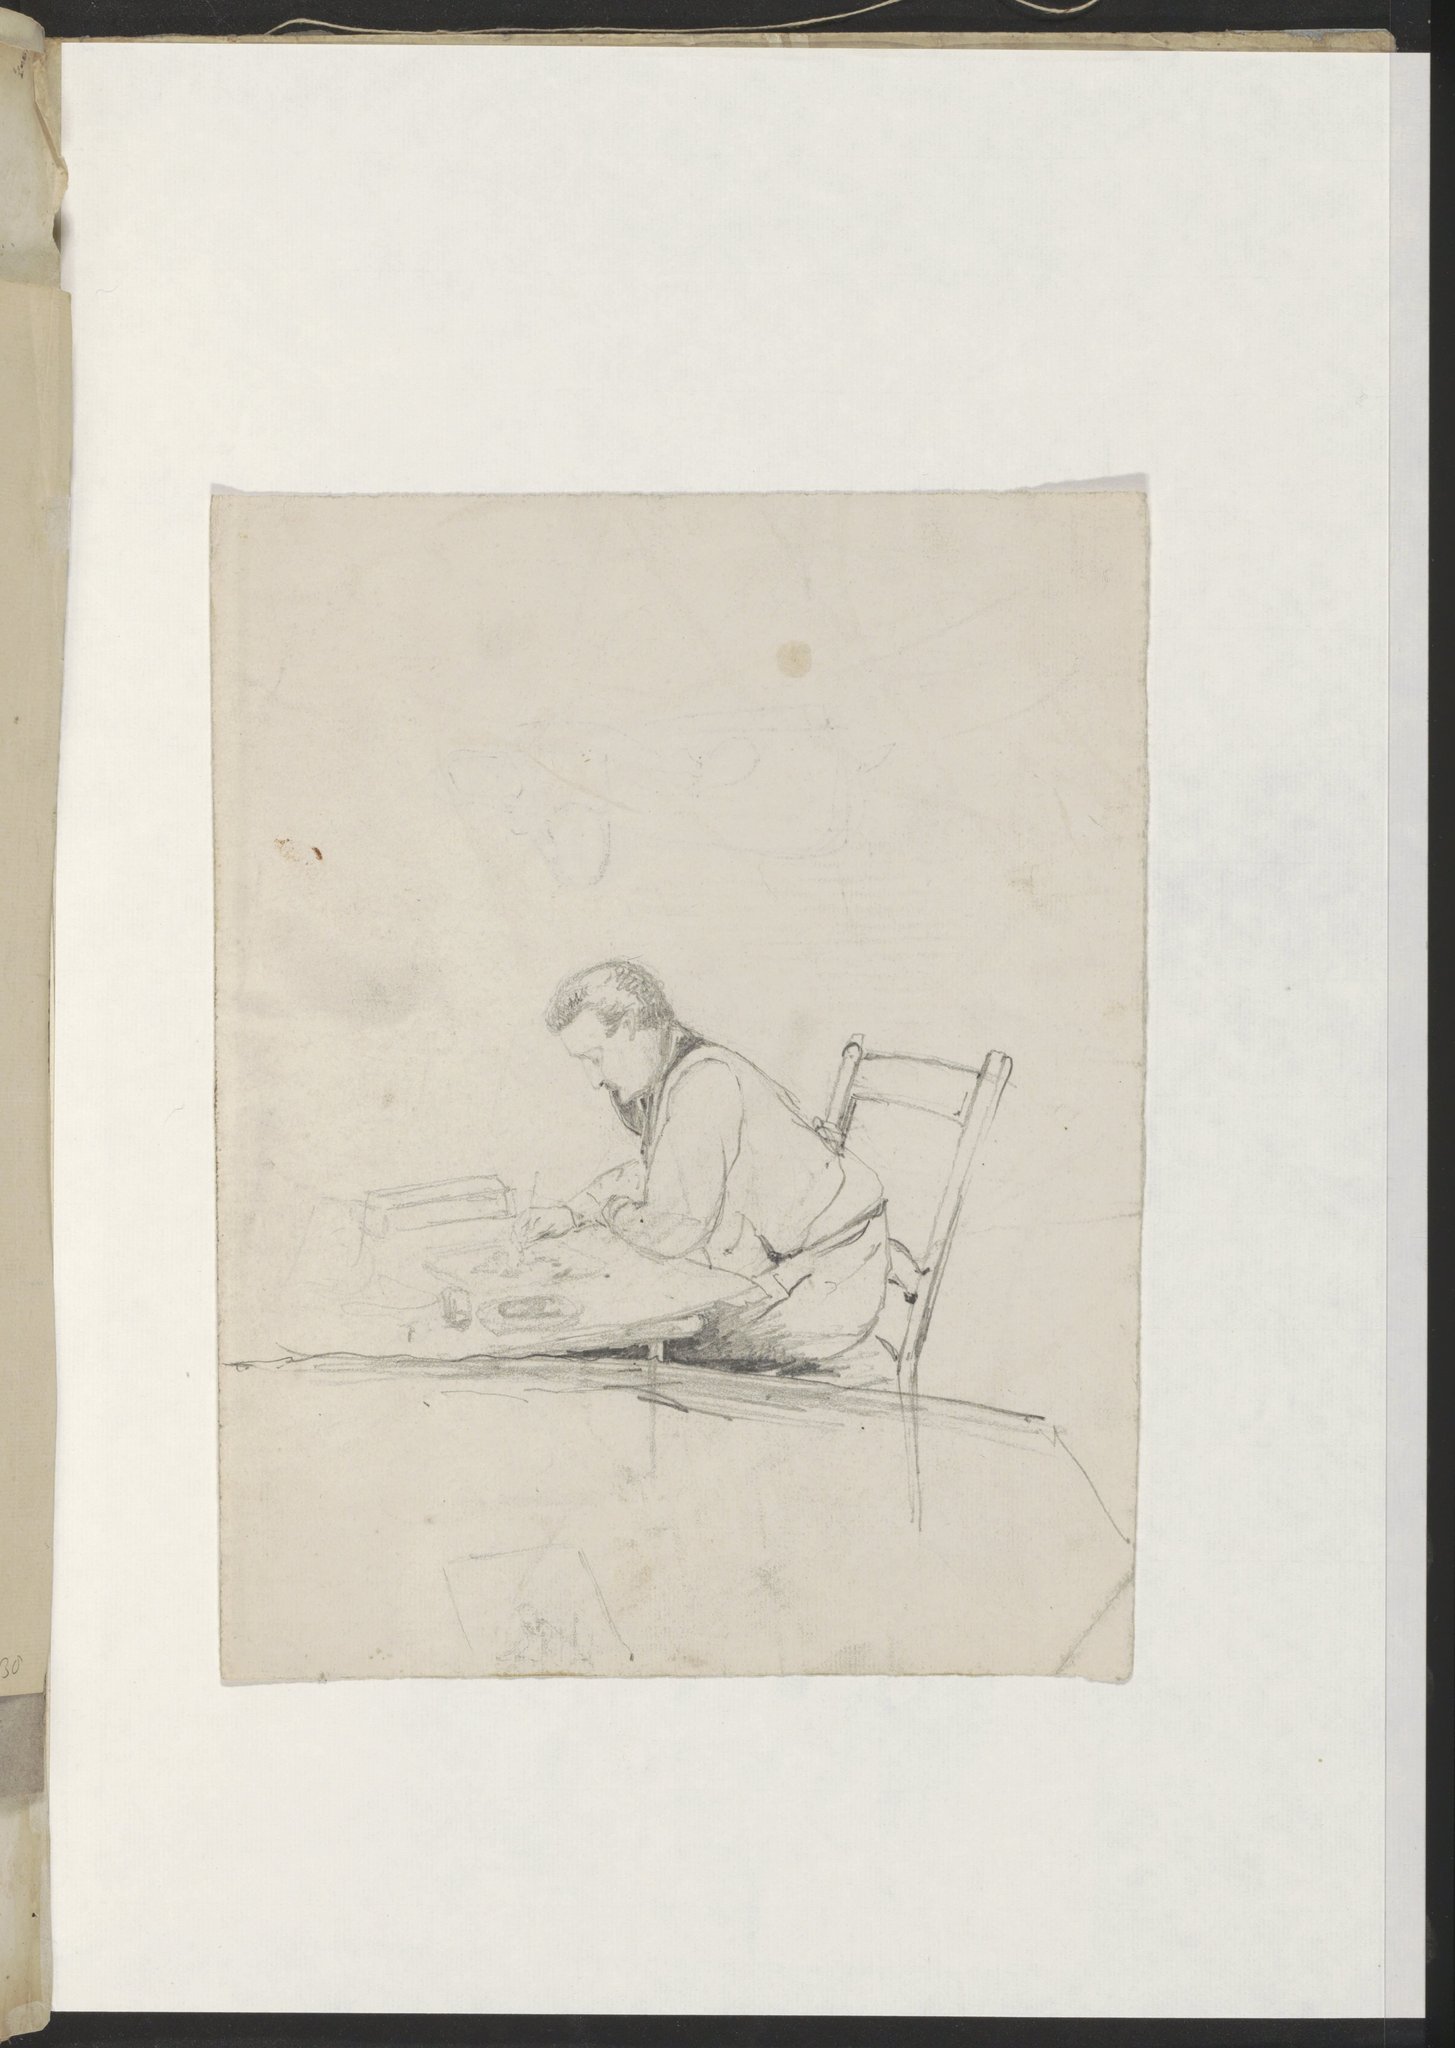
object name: sketchbook leaf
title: Tekenende man aan een tafel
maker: johannes huybertus van hove bzn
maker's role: print maker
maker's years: 1827-1881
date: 1837-1881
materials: paper, pencil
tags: drawing, table, artist at work, in his workshop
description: Blad 39 recto, los blad in een schetsboek met 33 bladen en 10 losse tekeningen.